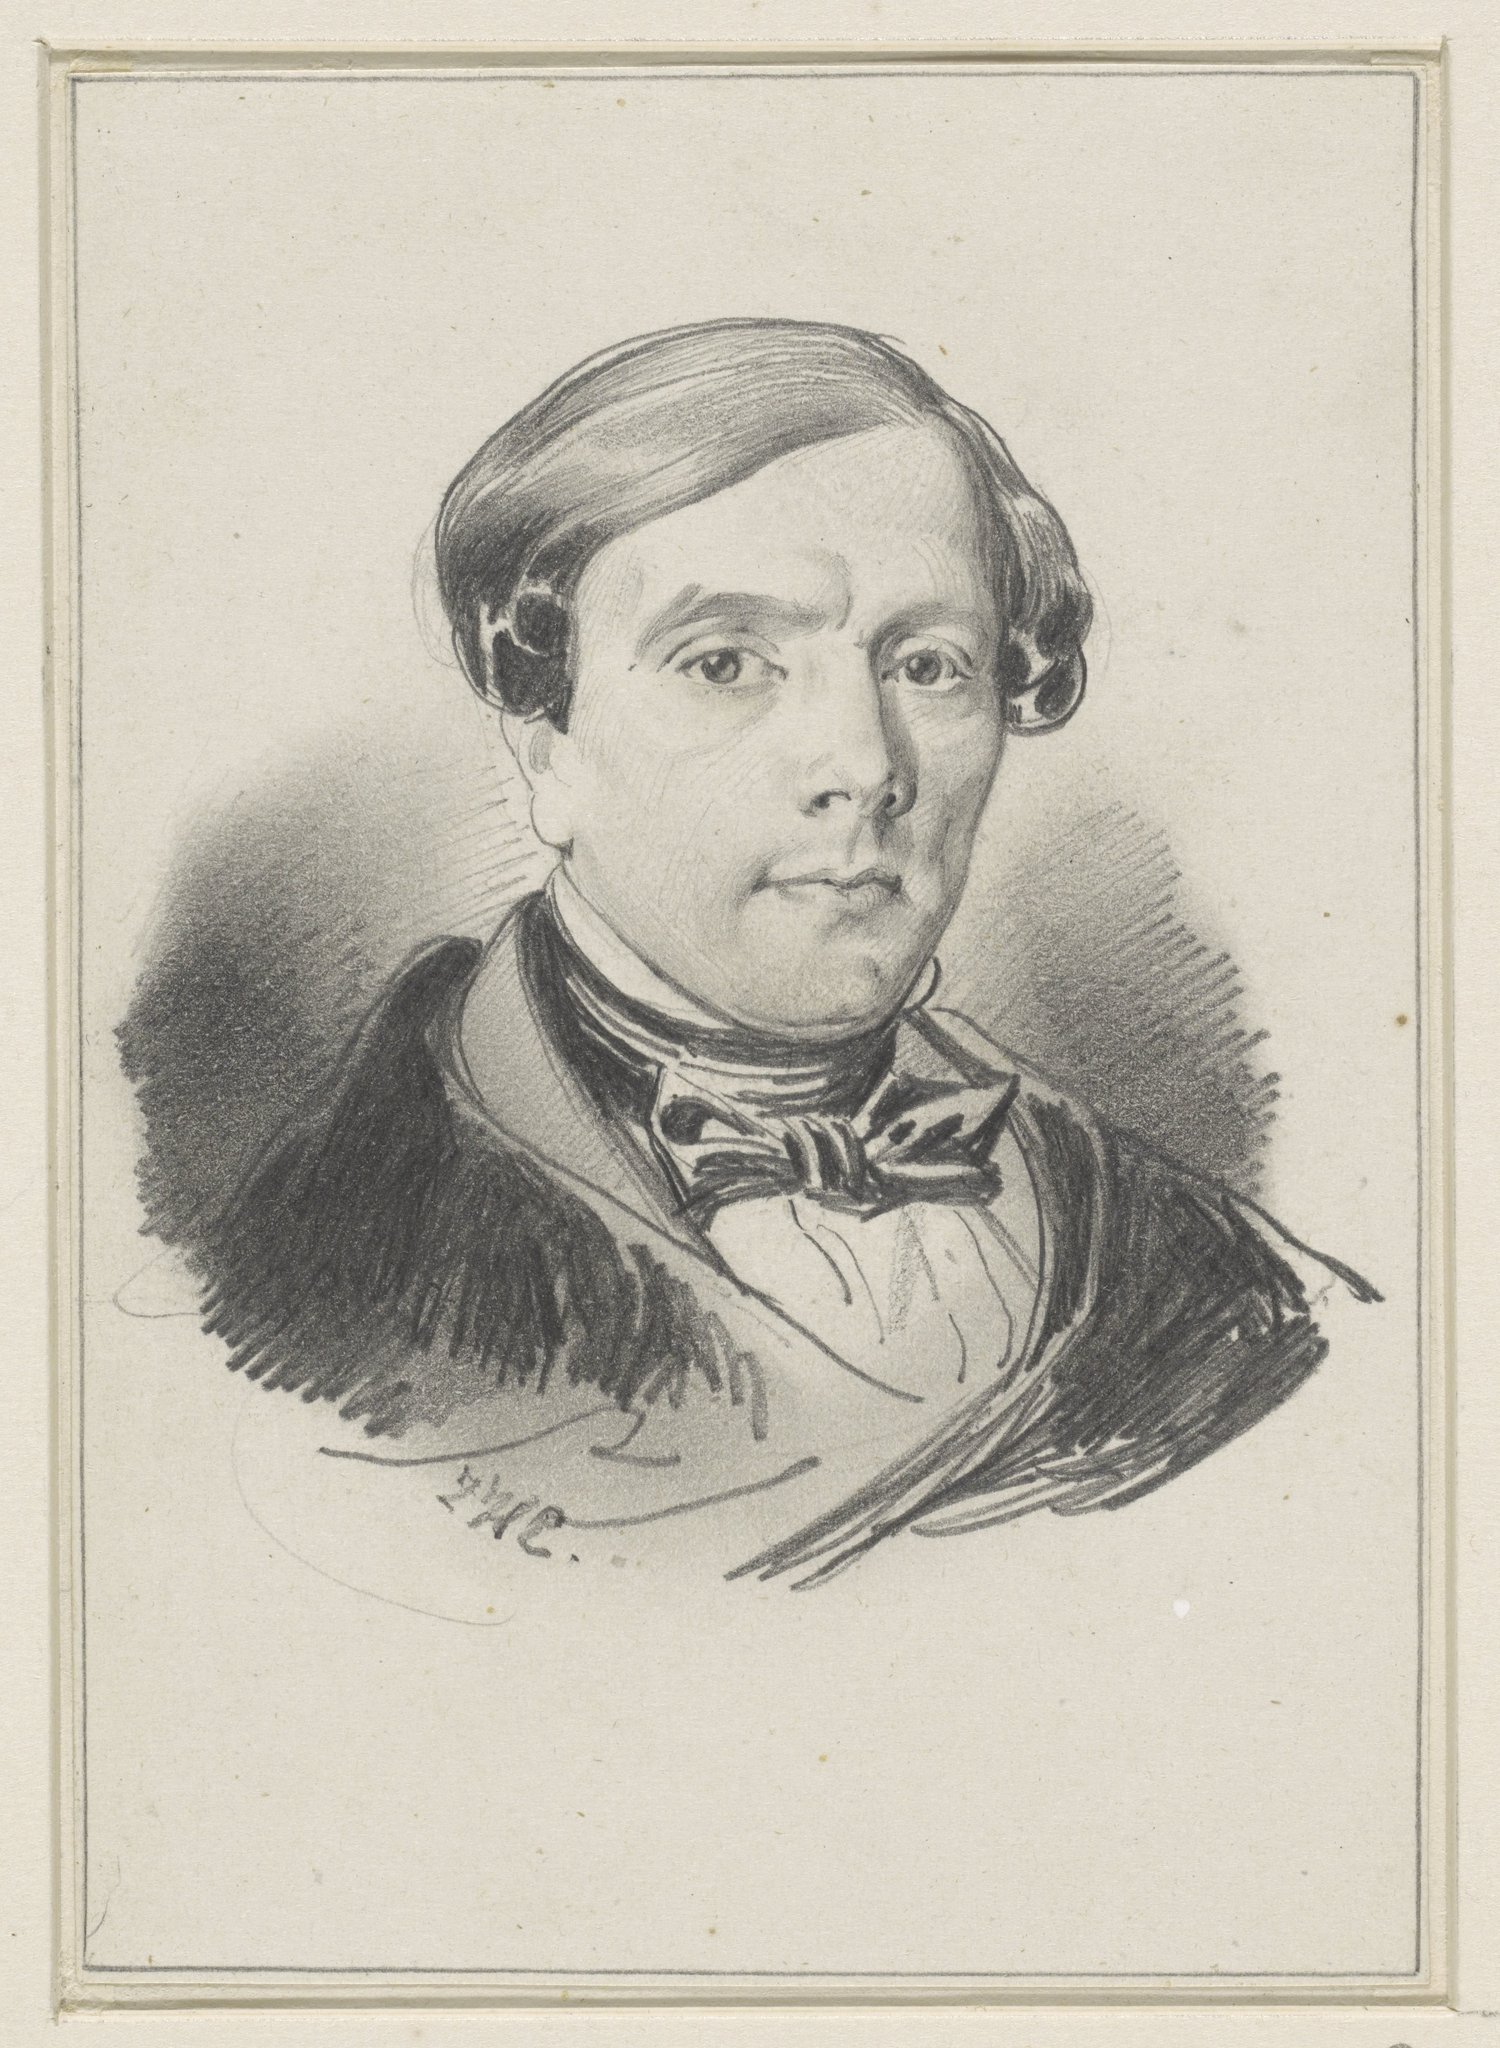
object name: drawing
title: Portret van de schilder en decorateur Jan Eduard de Vries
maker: johannes hinderikus egenberger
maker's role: draughtsman, print maker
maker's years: 1822-1897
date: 1832-1897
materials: paper, pencil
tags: amsterdam, painter, jan eduard de vries, historical persons, portrait, self-portrait of painter, portrait, self-portrait of artist